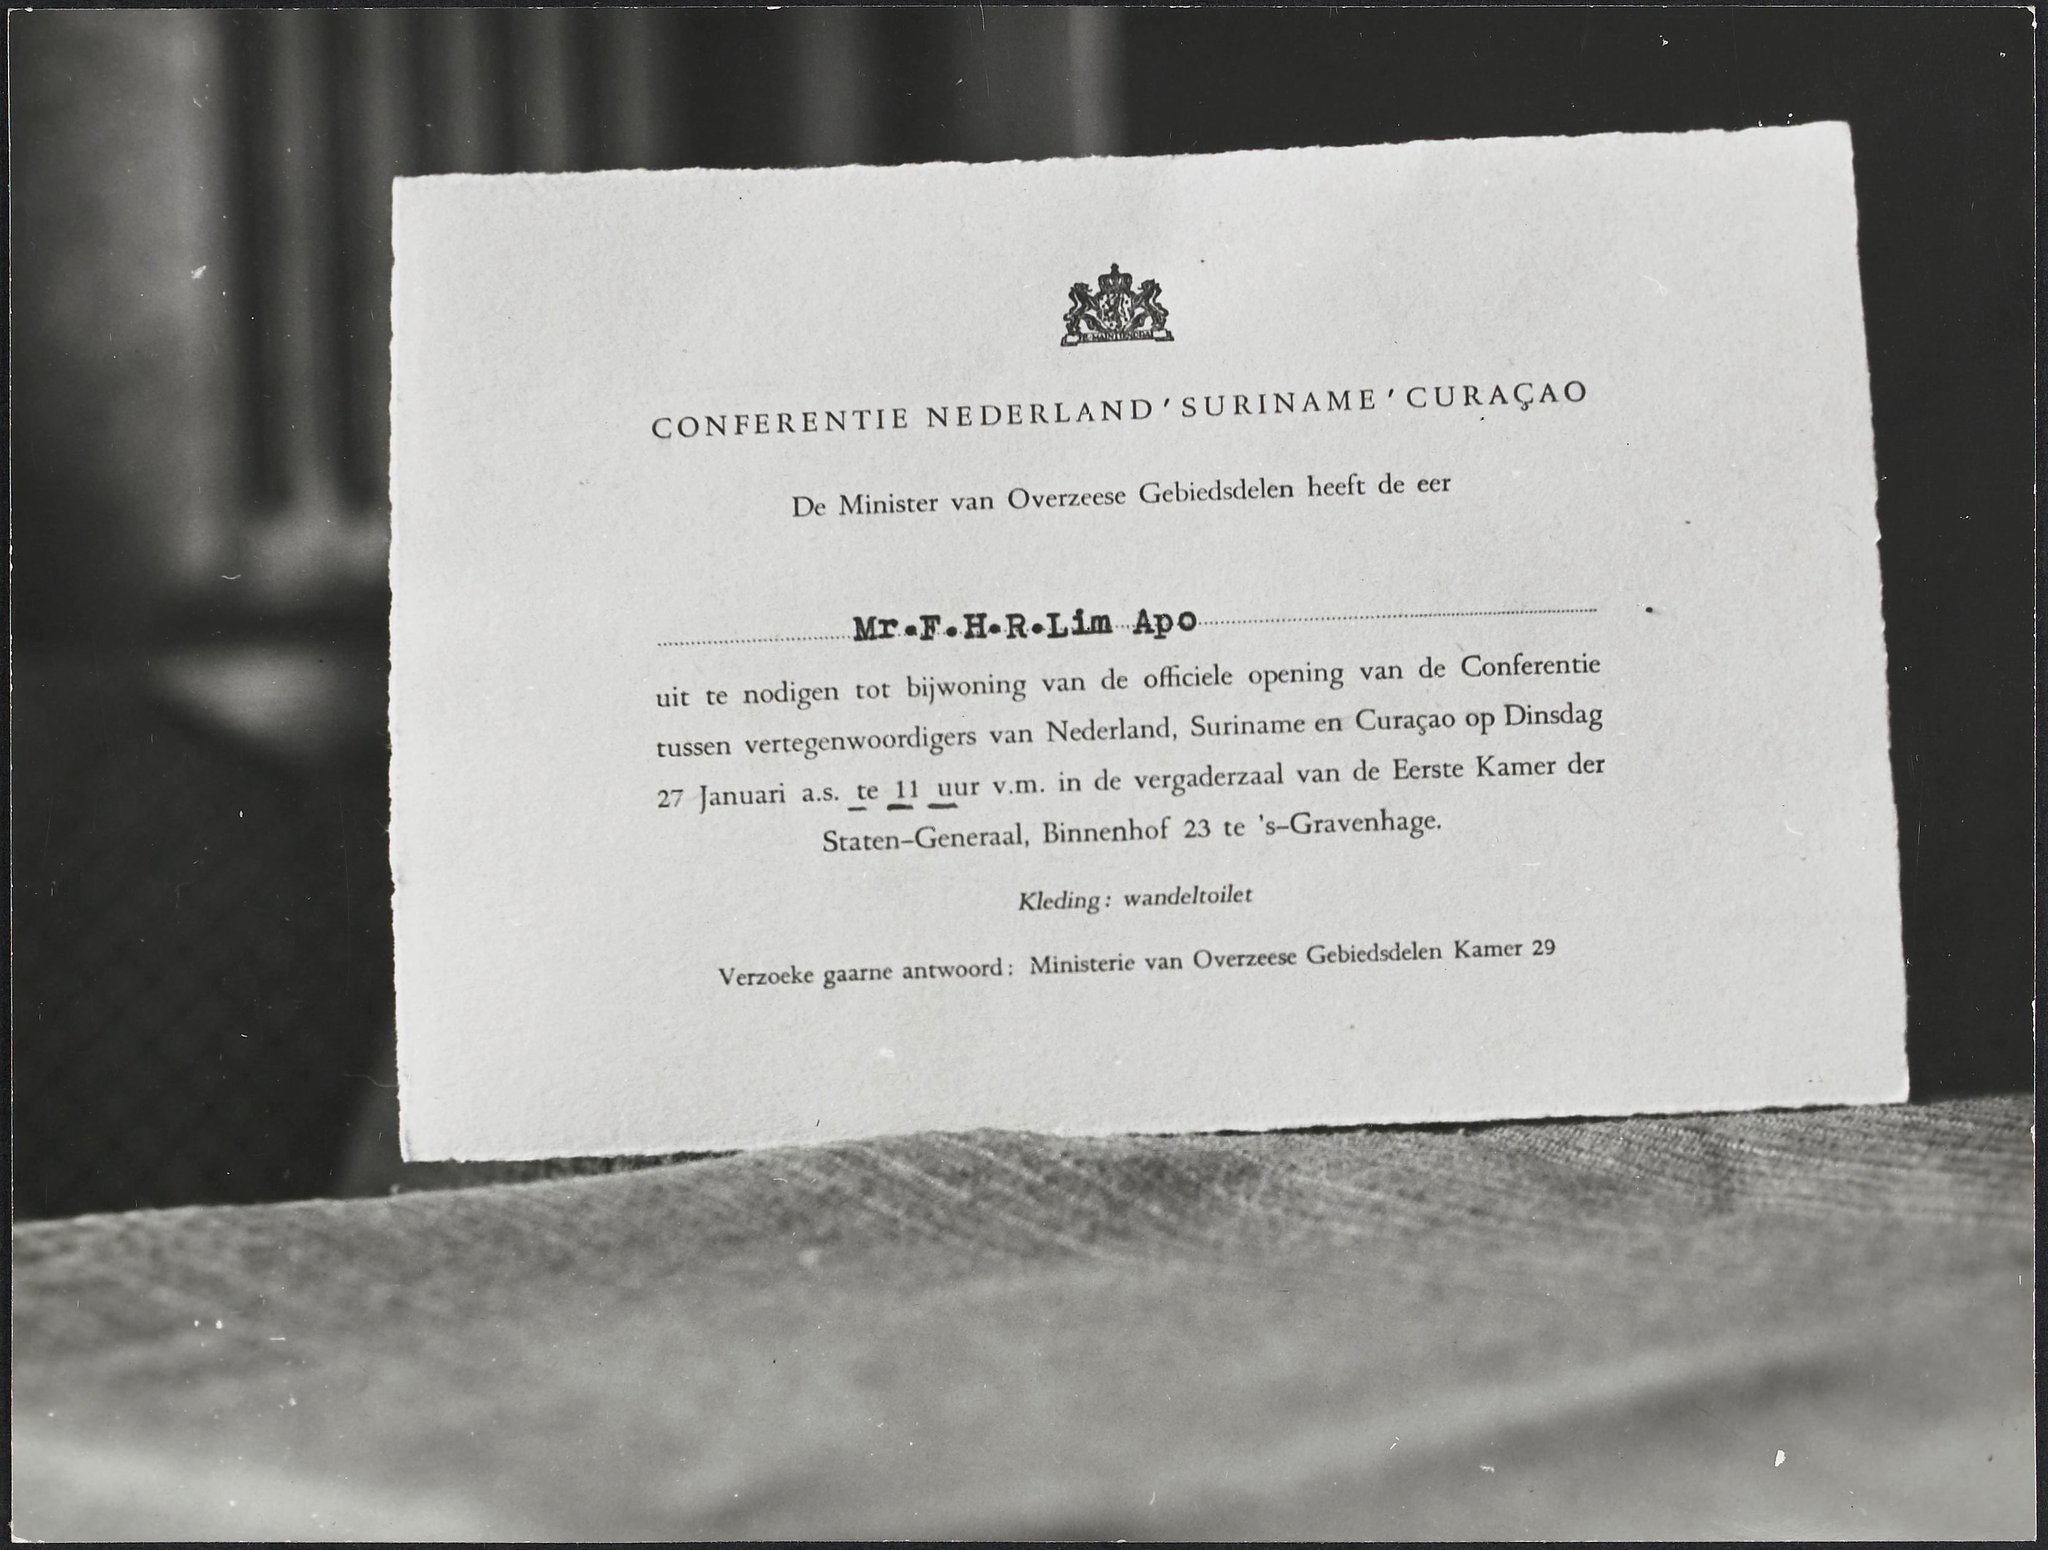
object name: documentary photograph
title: Uitnodiging voor de opening van de RTC voor de heer Lim A Po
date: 1902-1948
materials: photographic support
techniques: photography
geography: the hague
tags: netherlands, suriname, the hague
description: Foto van de uitnoding voor de heer F.H.R. Lim A Po voor de opening van de RTC op 27 januari om 11 uur in de vergaderzaal van de Eerste Kamer. Bij kleding staat: wandeltoilet.